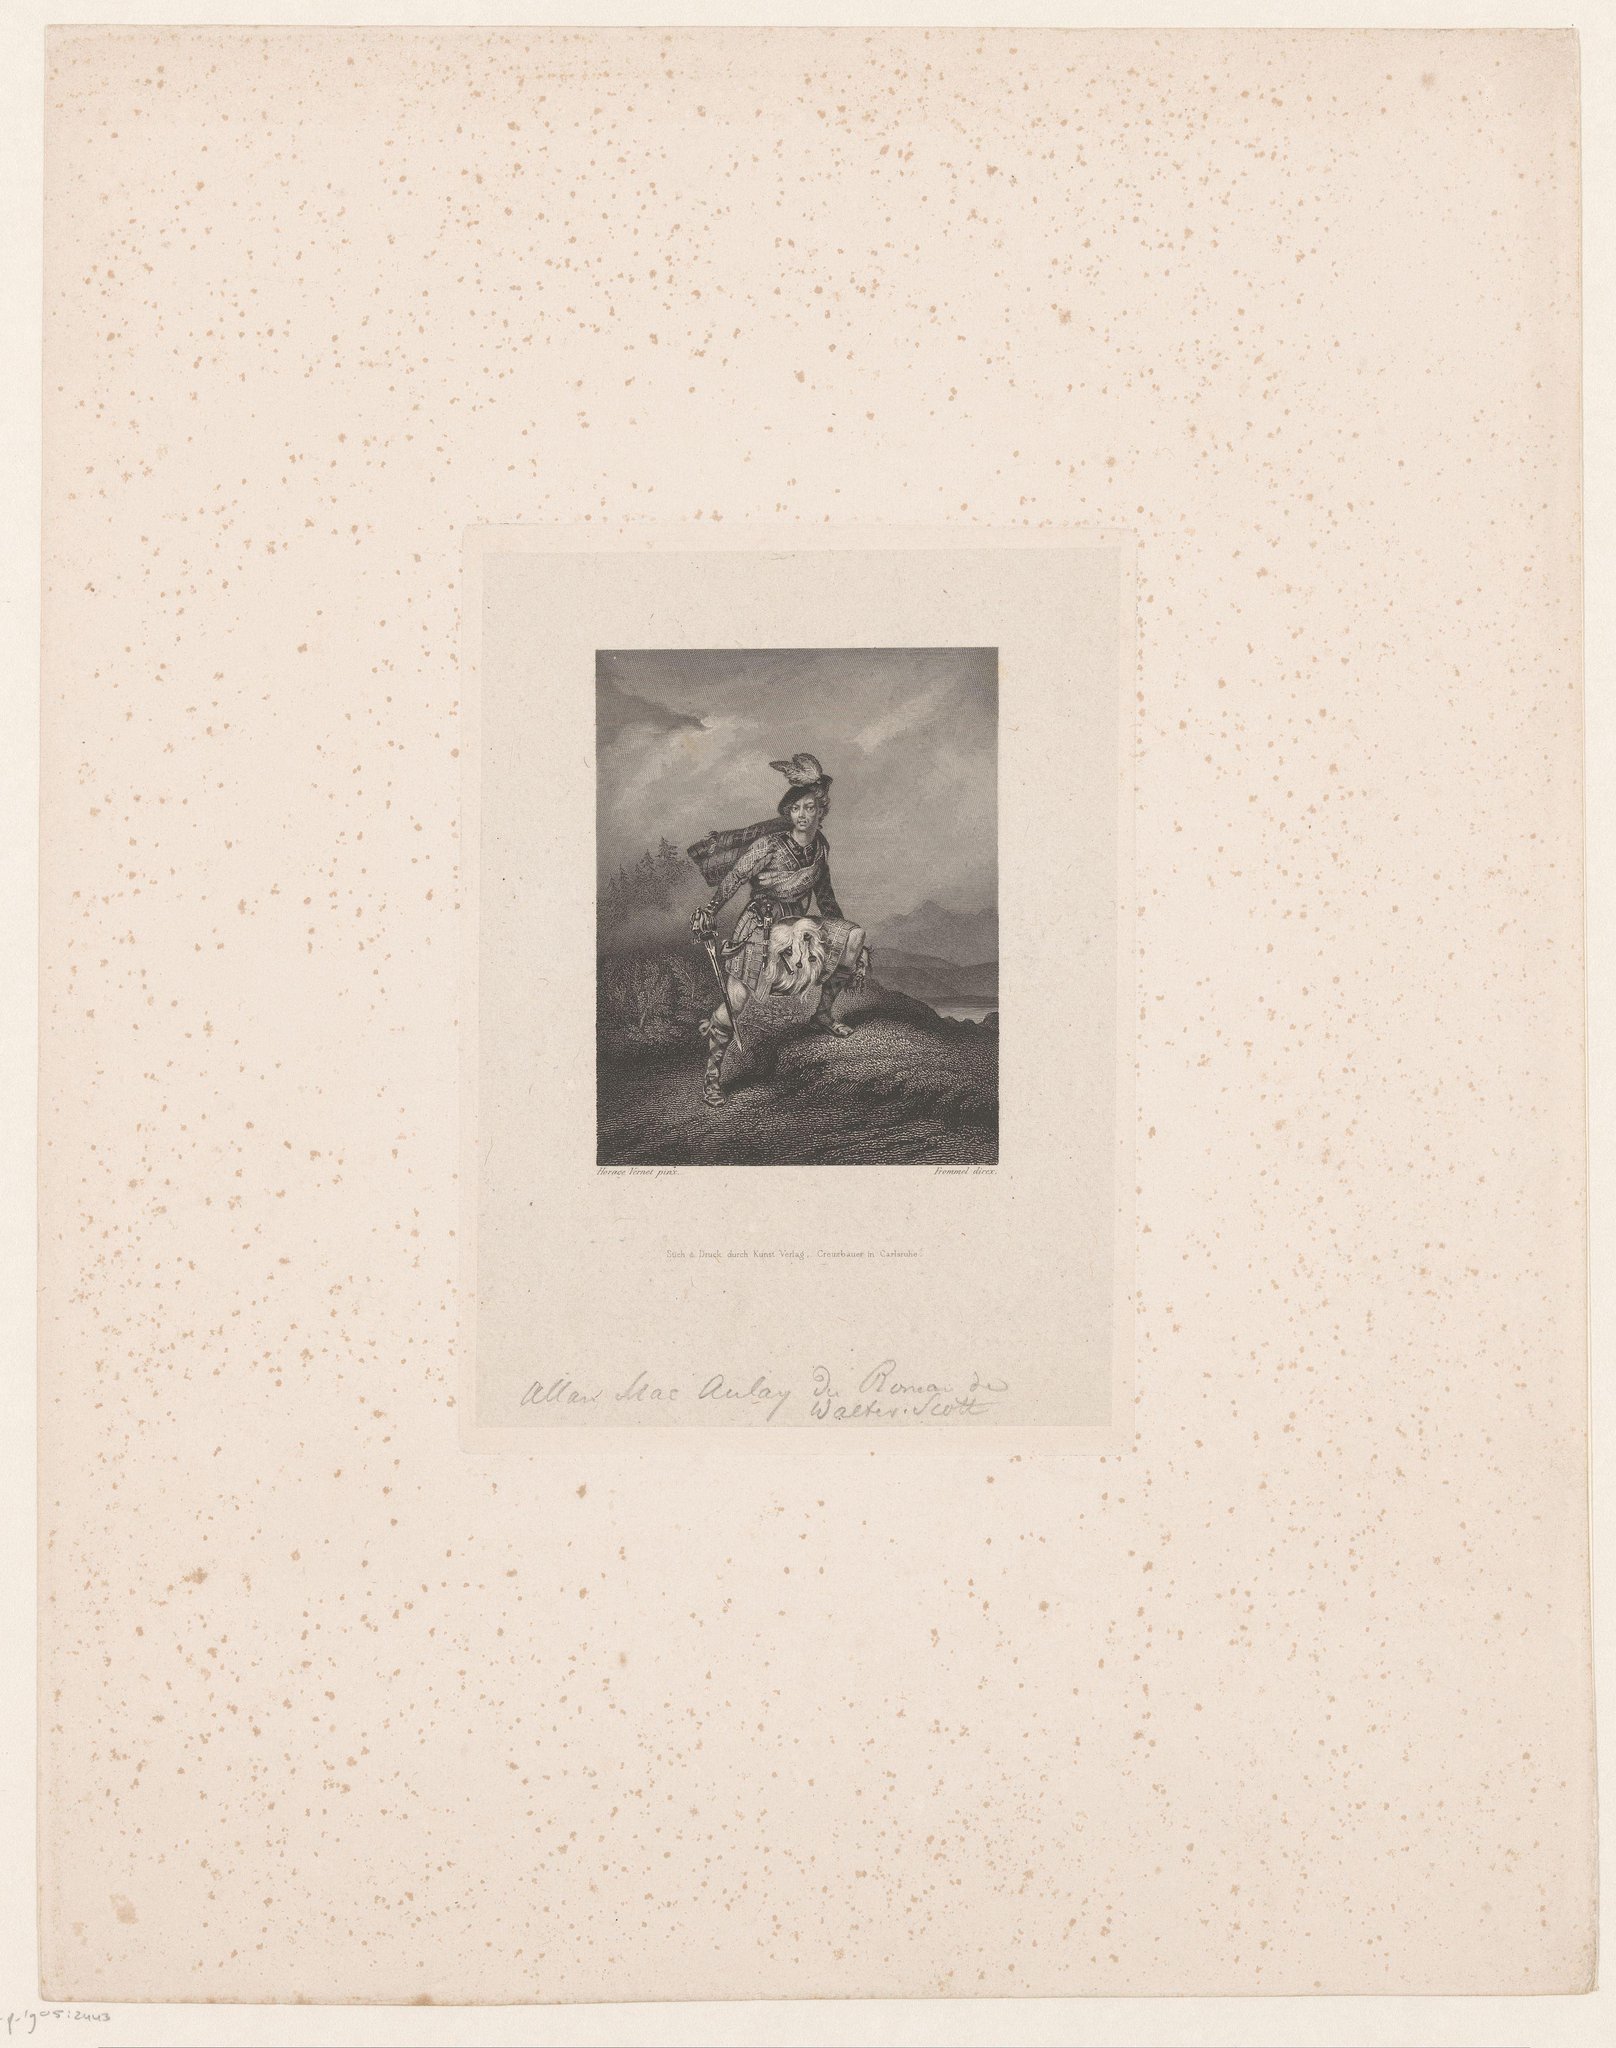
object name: print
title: Portret van Allan M'Aulay uit A Legend of Montrose van Walter Scott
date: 1824-1905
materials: paper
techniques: engraving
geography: karlsruhe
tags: walter scott, literary characters and objects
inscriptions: collector's mark: Lugt 2228, : ‘Allan Mac Aulay du roman de Walter Scott’